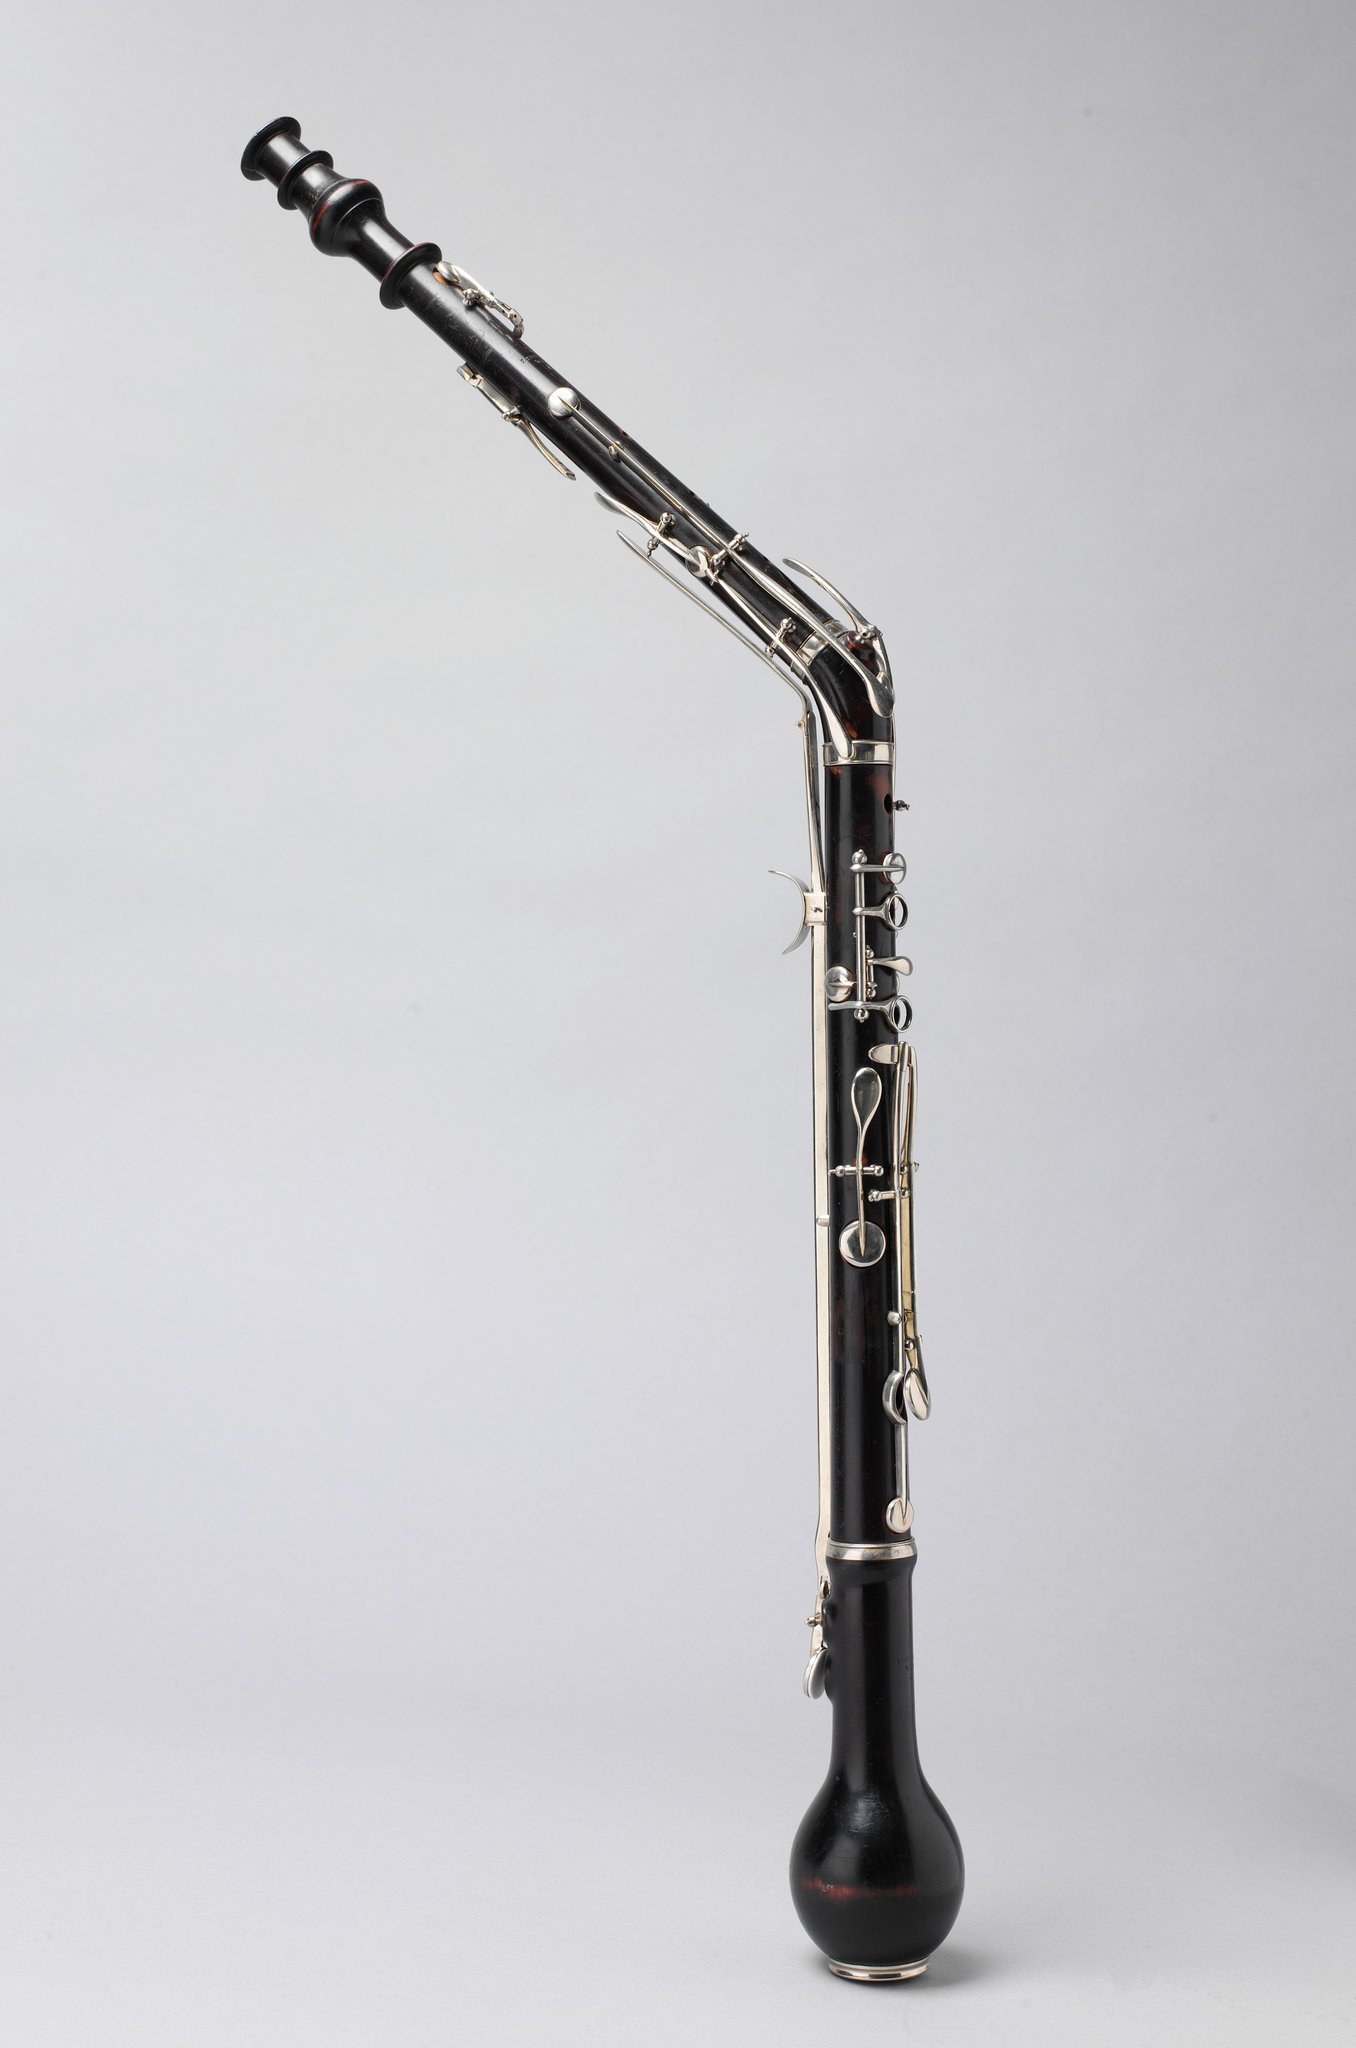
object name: english horn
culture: austrian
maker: johann tobias uhlmann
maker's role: maker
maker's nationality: austrian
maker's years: 1776-1838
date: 1860-1870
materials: wood, nickel, silver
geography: austria